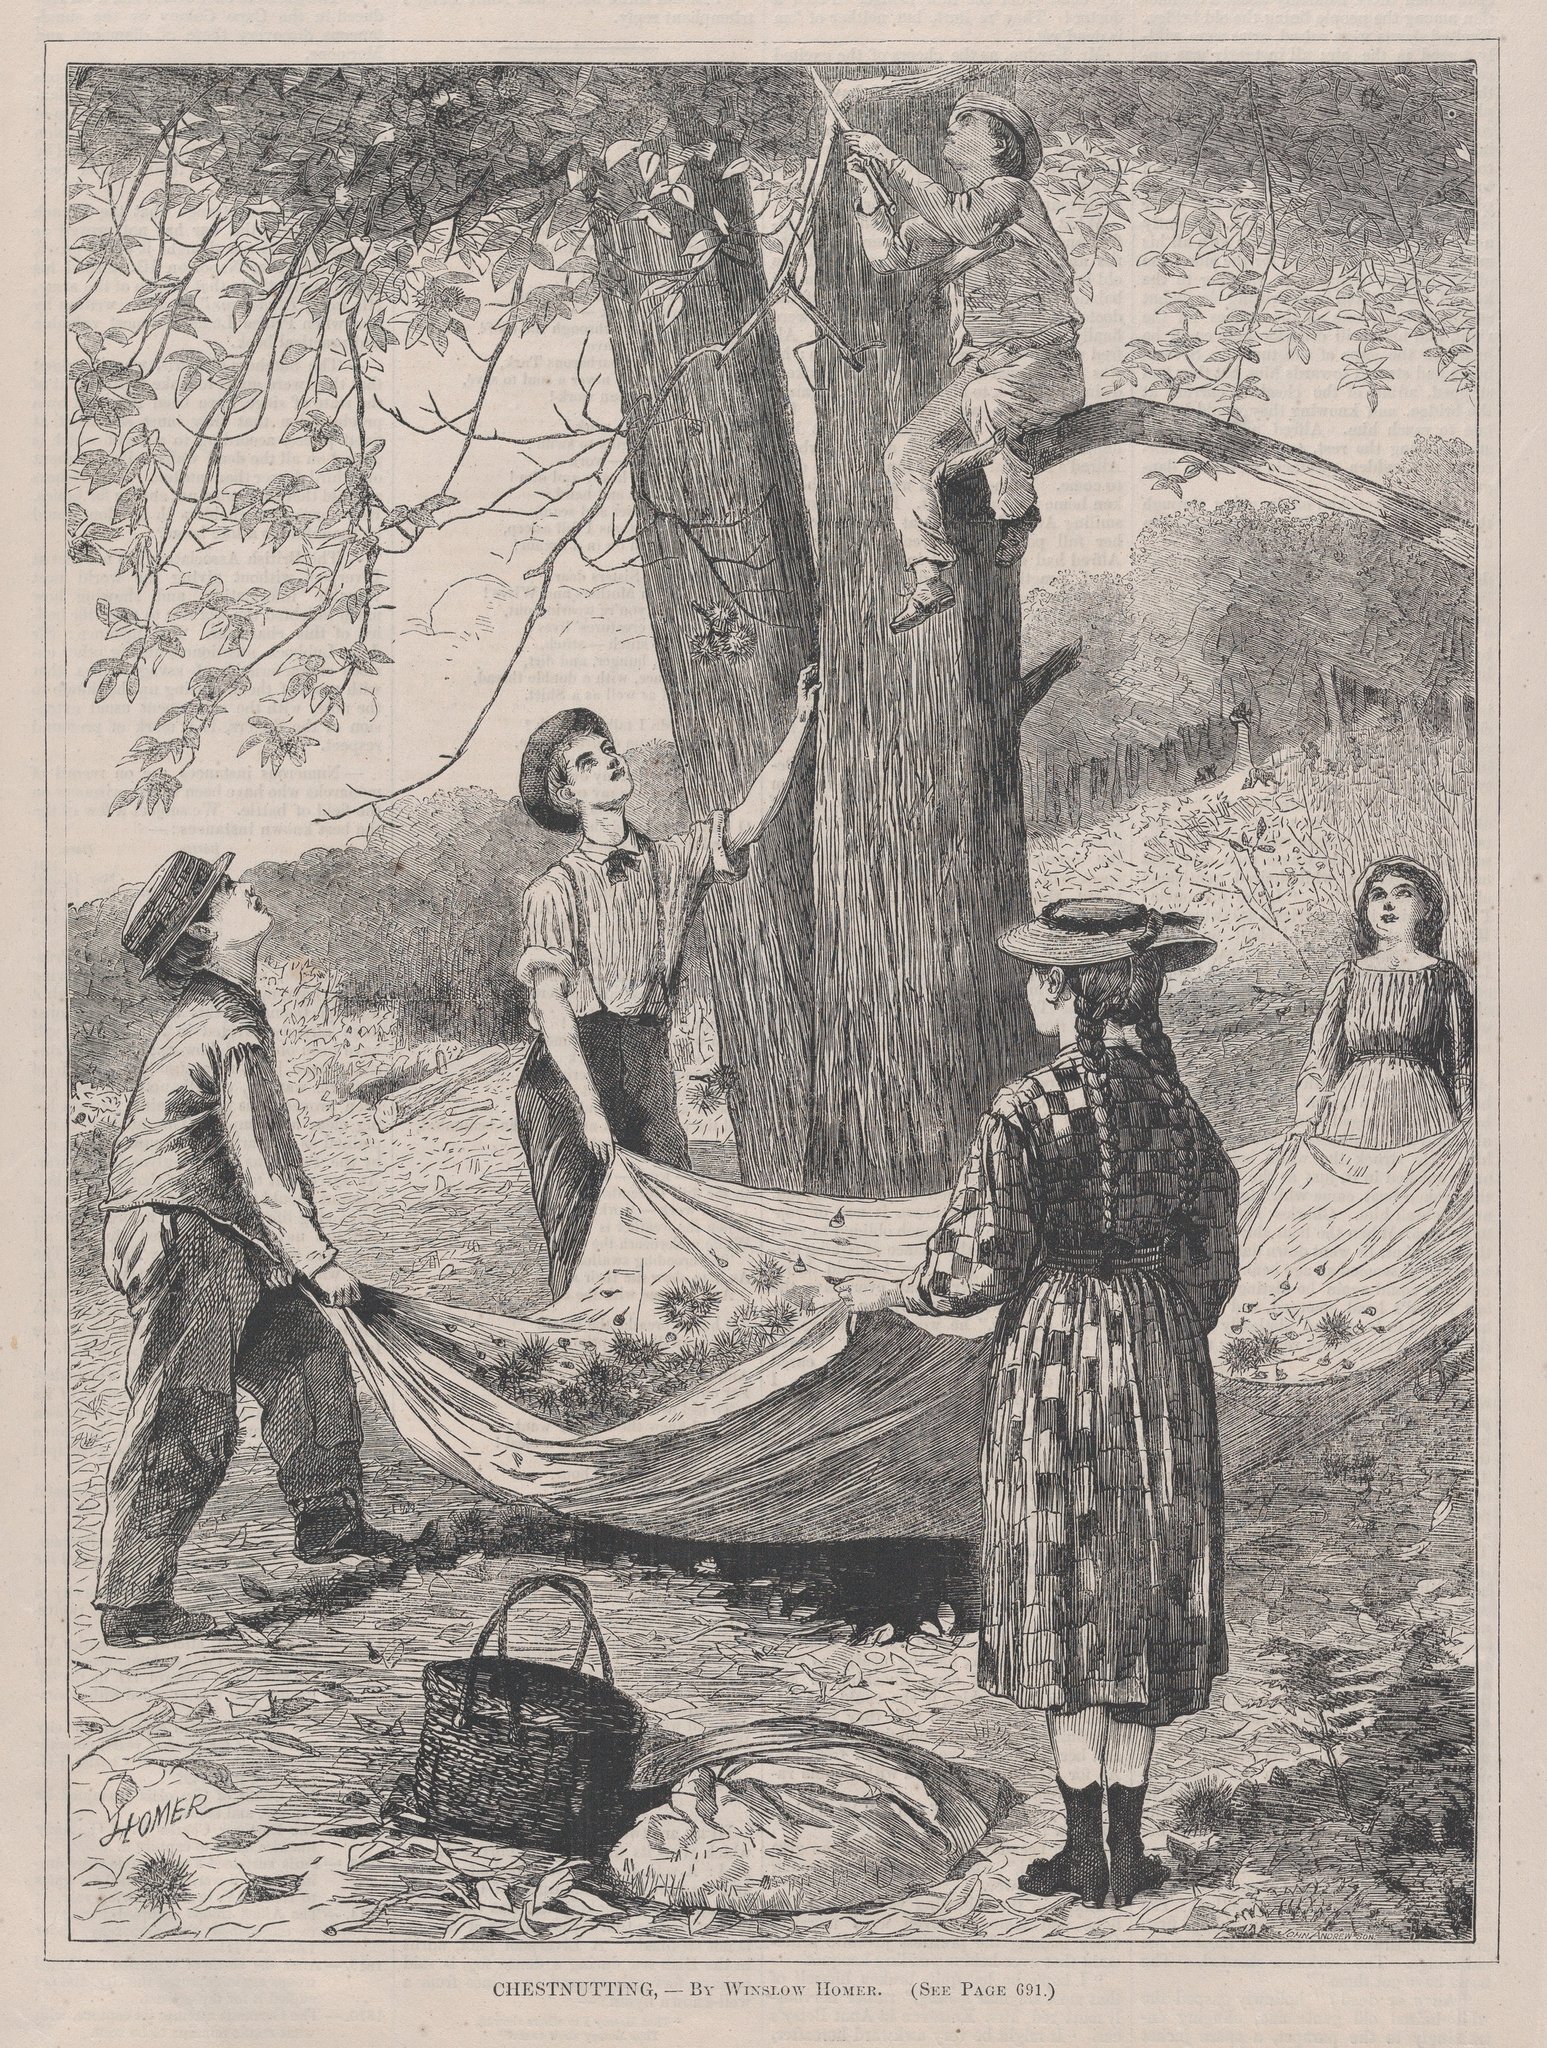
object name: print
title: Chestnutting (from "Every Saturday," Vol. I, New Series)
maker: winslow homer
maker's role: artist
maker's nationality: american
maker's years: 1836-1910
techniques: engraving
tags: boys,girls,trees